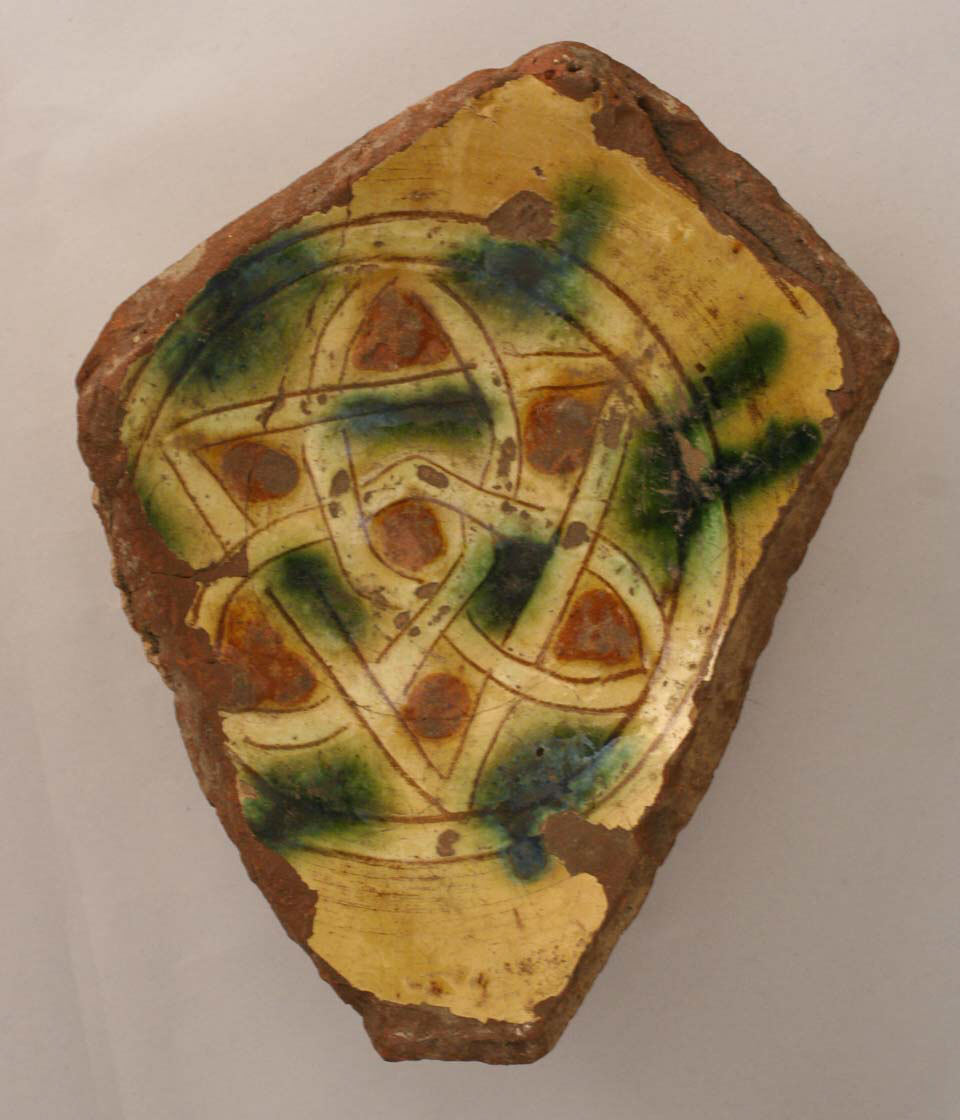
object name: fragment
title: Fragment of a Bowl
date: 1301-1500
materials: earthenware, glaze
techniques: coloring, incising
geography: egypt